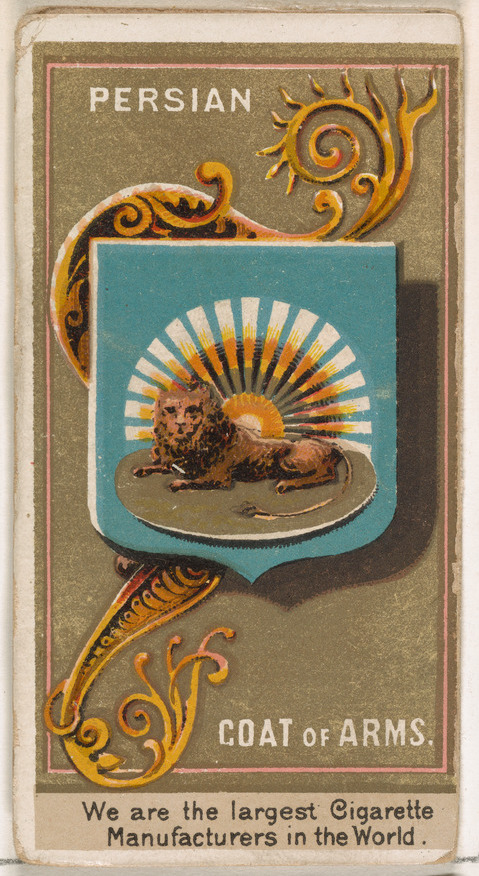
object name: print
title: Shah of Persia, from the Rulers, Flags, and Coats of Arms series (N126-2) issued by W. Duke, Sons & Co.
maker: w. duke, sons & co.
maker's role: publisher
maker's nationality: american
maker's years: 1870-1920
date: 1888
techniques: color lithograph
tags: men,portraits,women,lions,flags